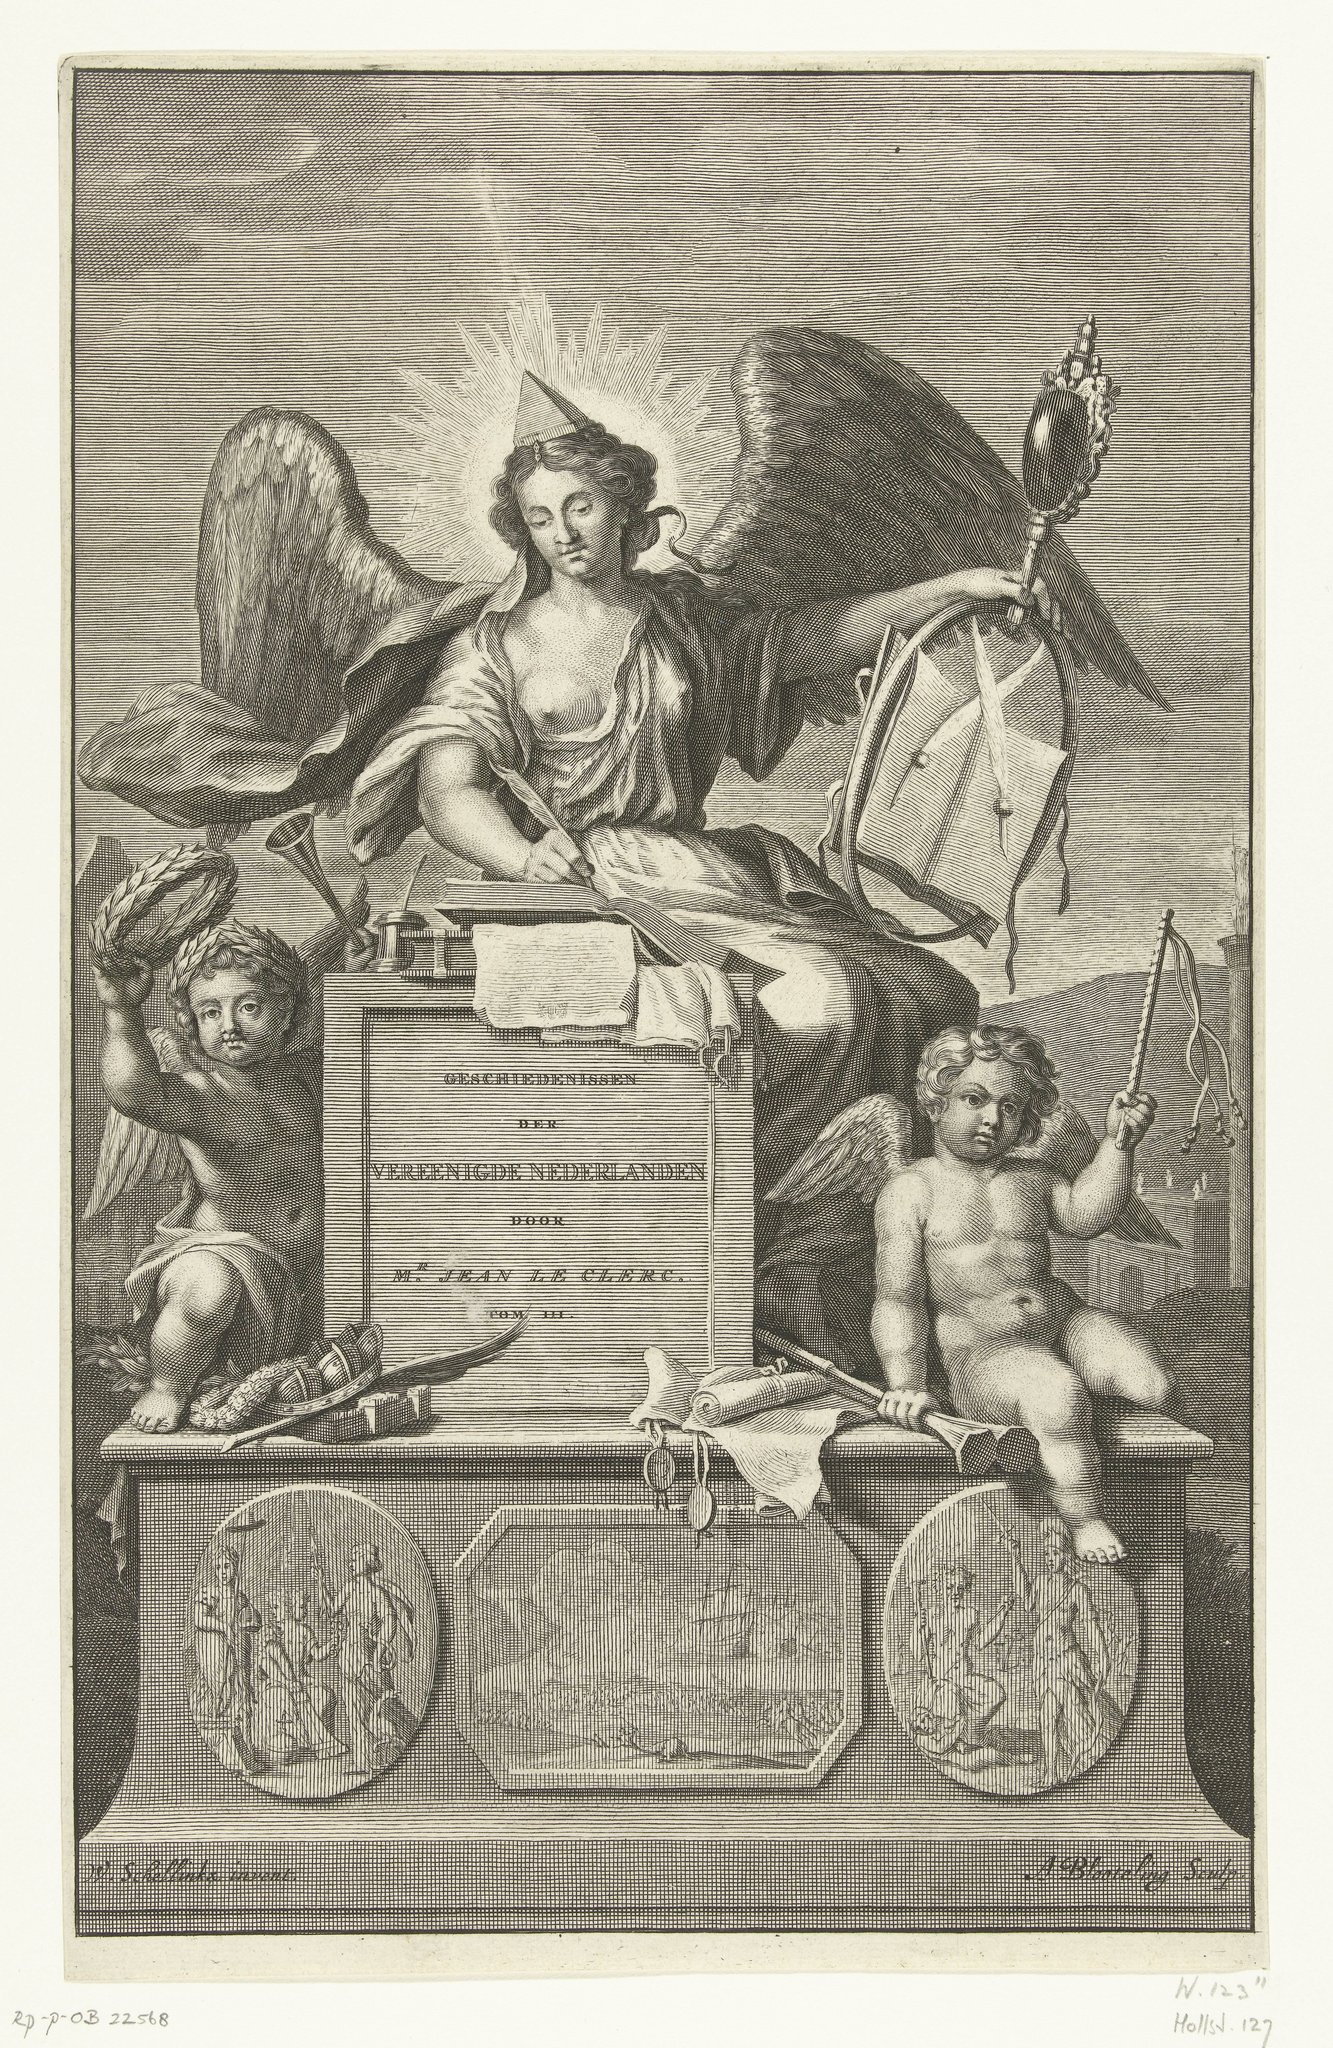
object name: titelblad, titelpagina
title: Titelpagina voor: J. Le Clerc, Geschiedenissen der Vereenigde Nederlanden, dl. III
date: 1650-1679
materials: paper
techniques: engraving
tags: 'historia'; 'historia' (ripa)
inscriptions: collector's mark: Lugt 2228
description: Titelprent voor een uitgave van: J. Le Clerc, Geschiedenissen der Vereenigde Nederlanden, dl. III. Heeft vroeger ook gediend voor dl. I van P. Bor, Nederl. Oorlogen, Amsterdam 1679.